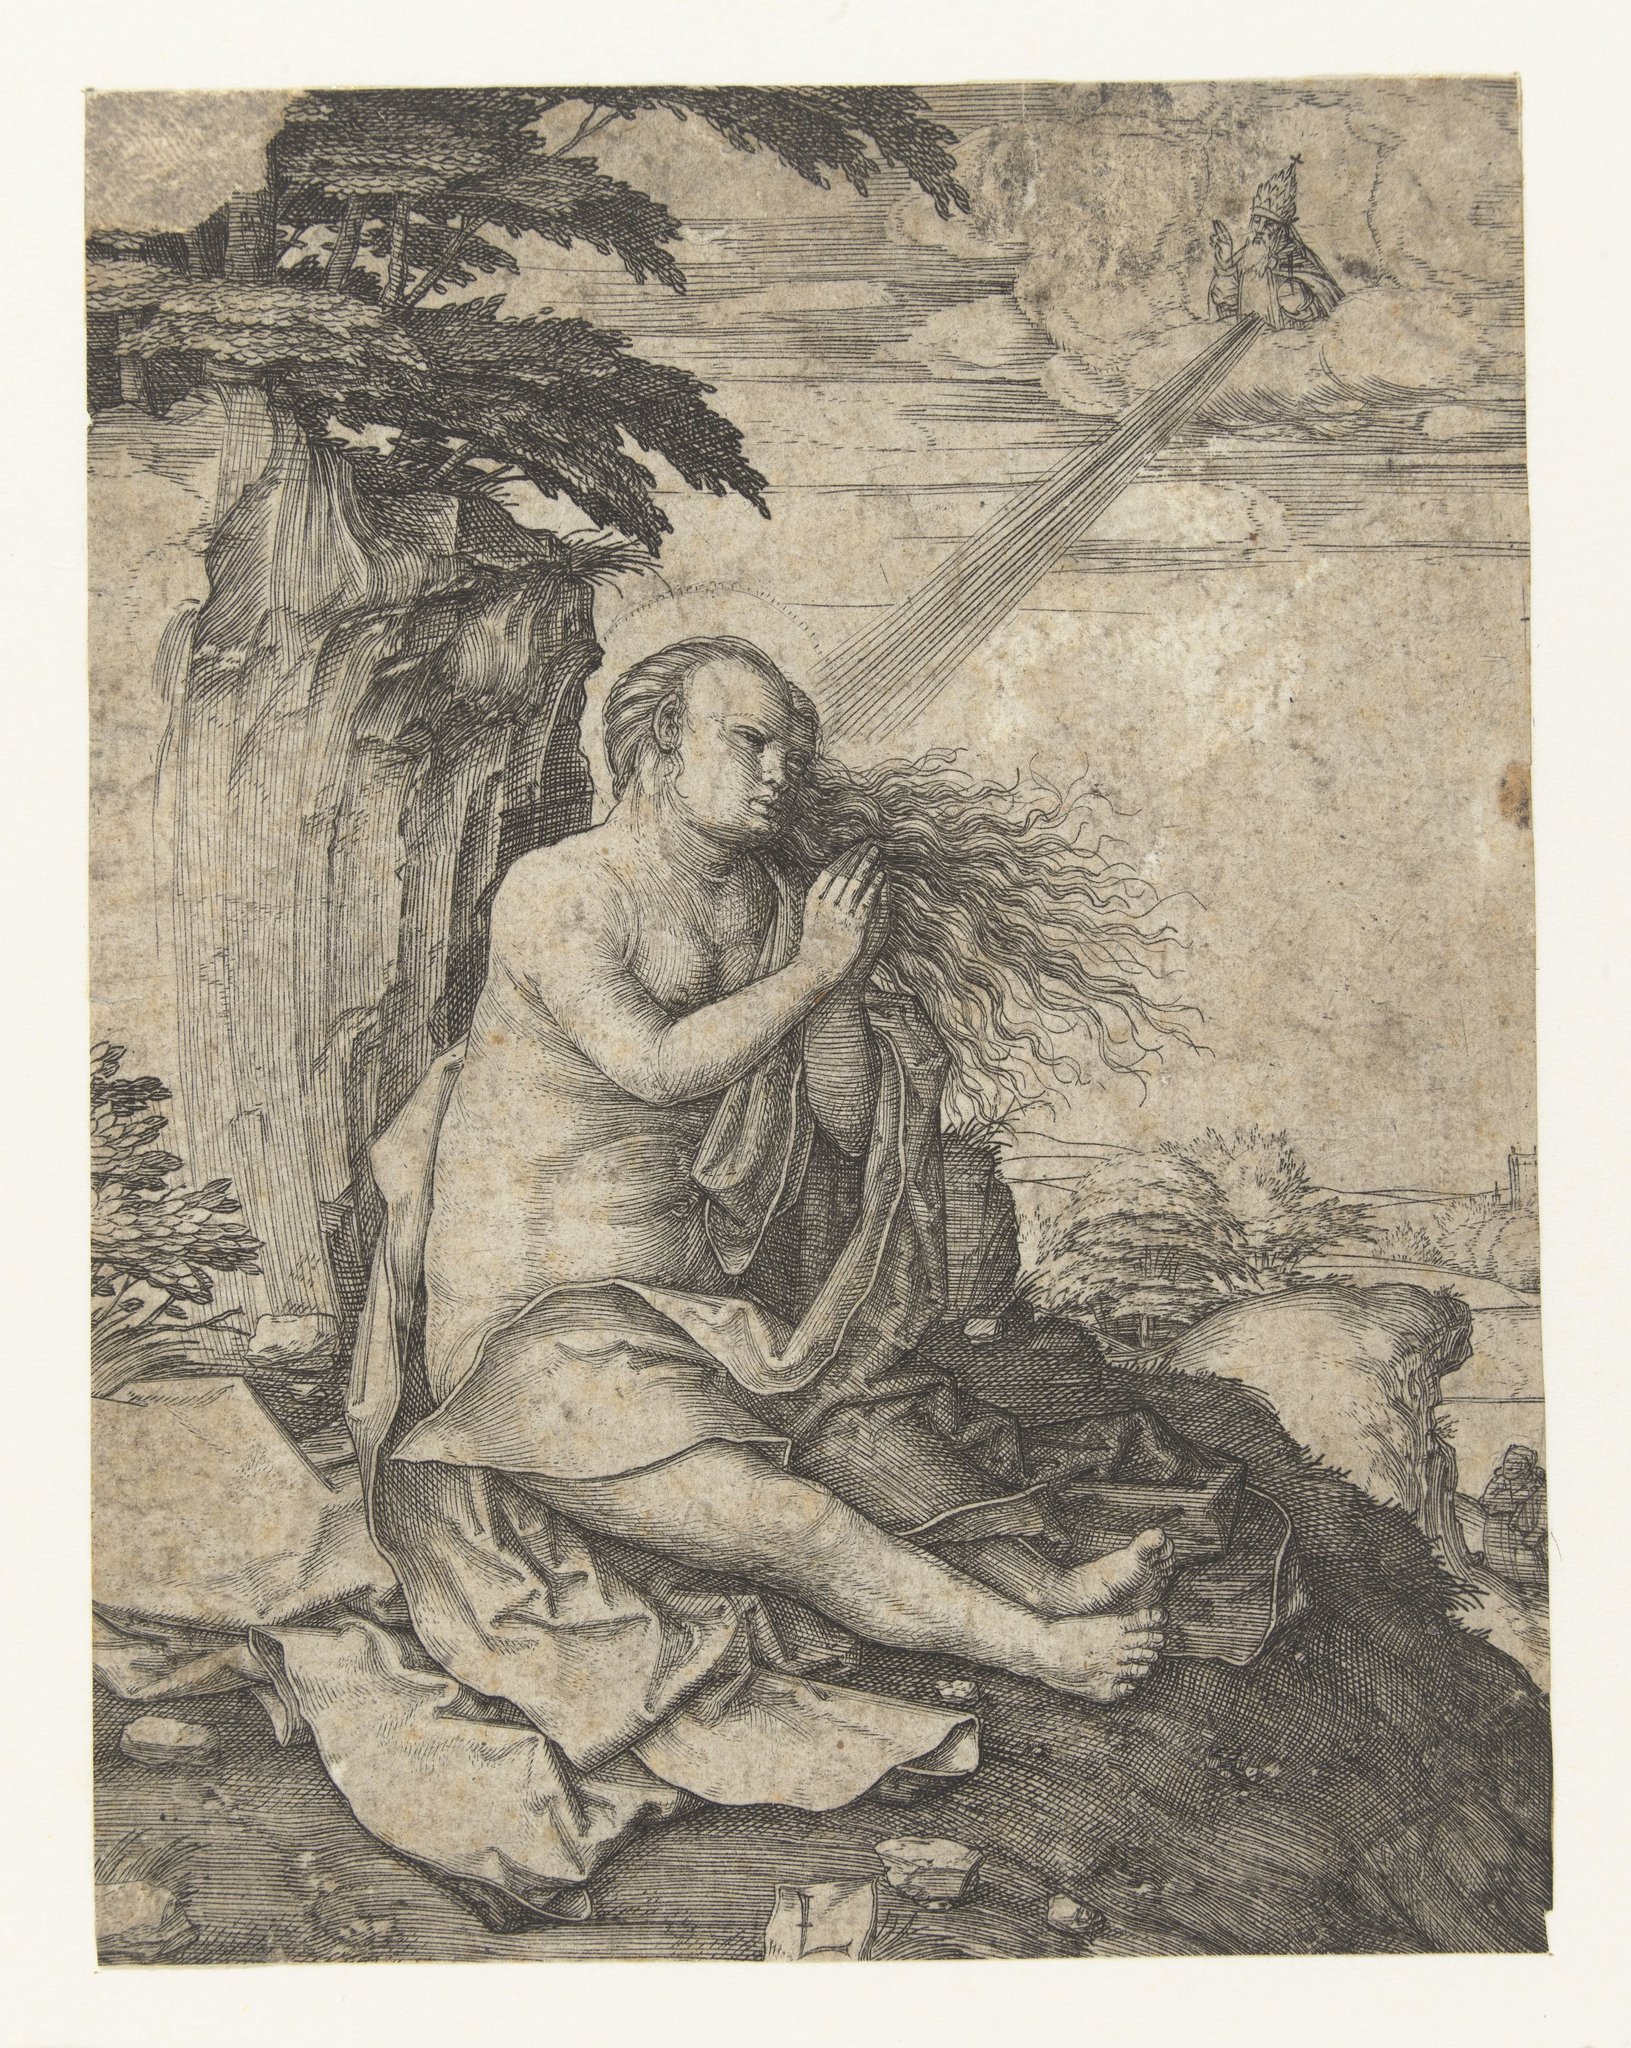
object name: print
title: Maria Magdalena in de woestijn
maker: lucas van leyden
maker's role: draughtsman, painter, print maker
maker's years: 1494-1533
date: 1504-1508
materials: paper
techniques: engraving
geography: low countries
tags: the penitent st. mary magdalene (often before a cave, possibly at la sainte-baume hill): her long hair covers her (naked) body, she reads, meditates or raises her tear-filled eyes towards heaven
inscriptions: signature: ‘L’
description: Maria Magdalena half naakt zittend in een landschap, aan de hemel God de Vader.